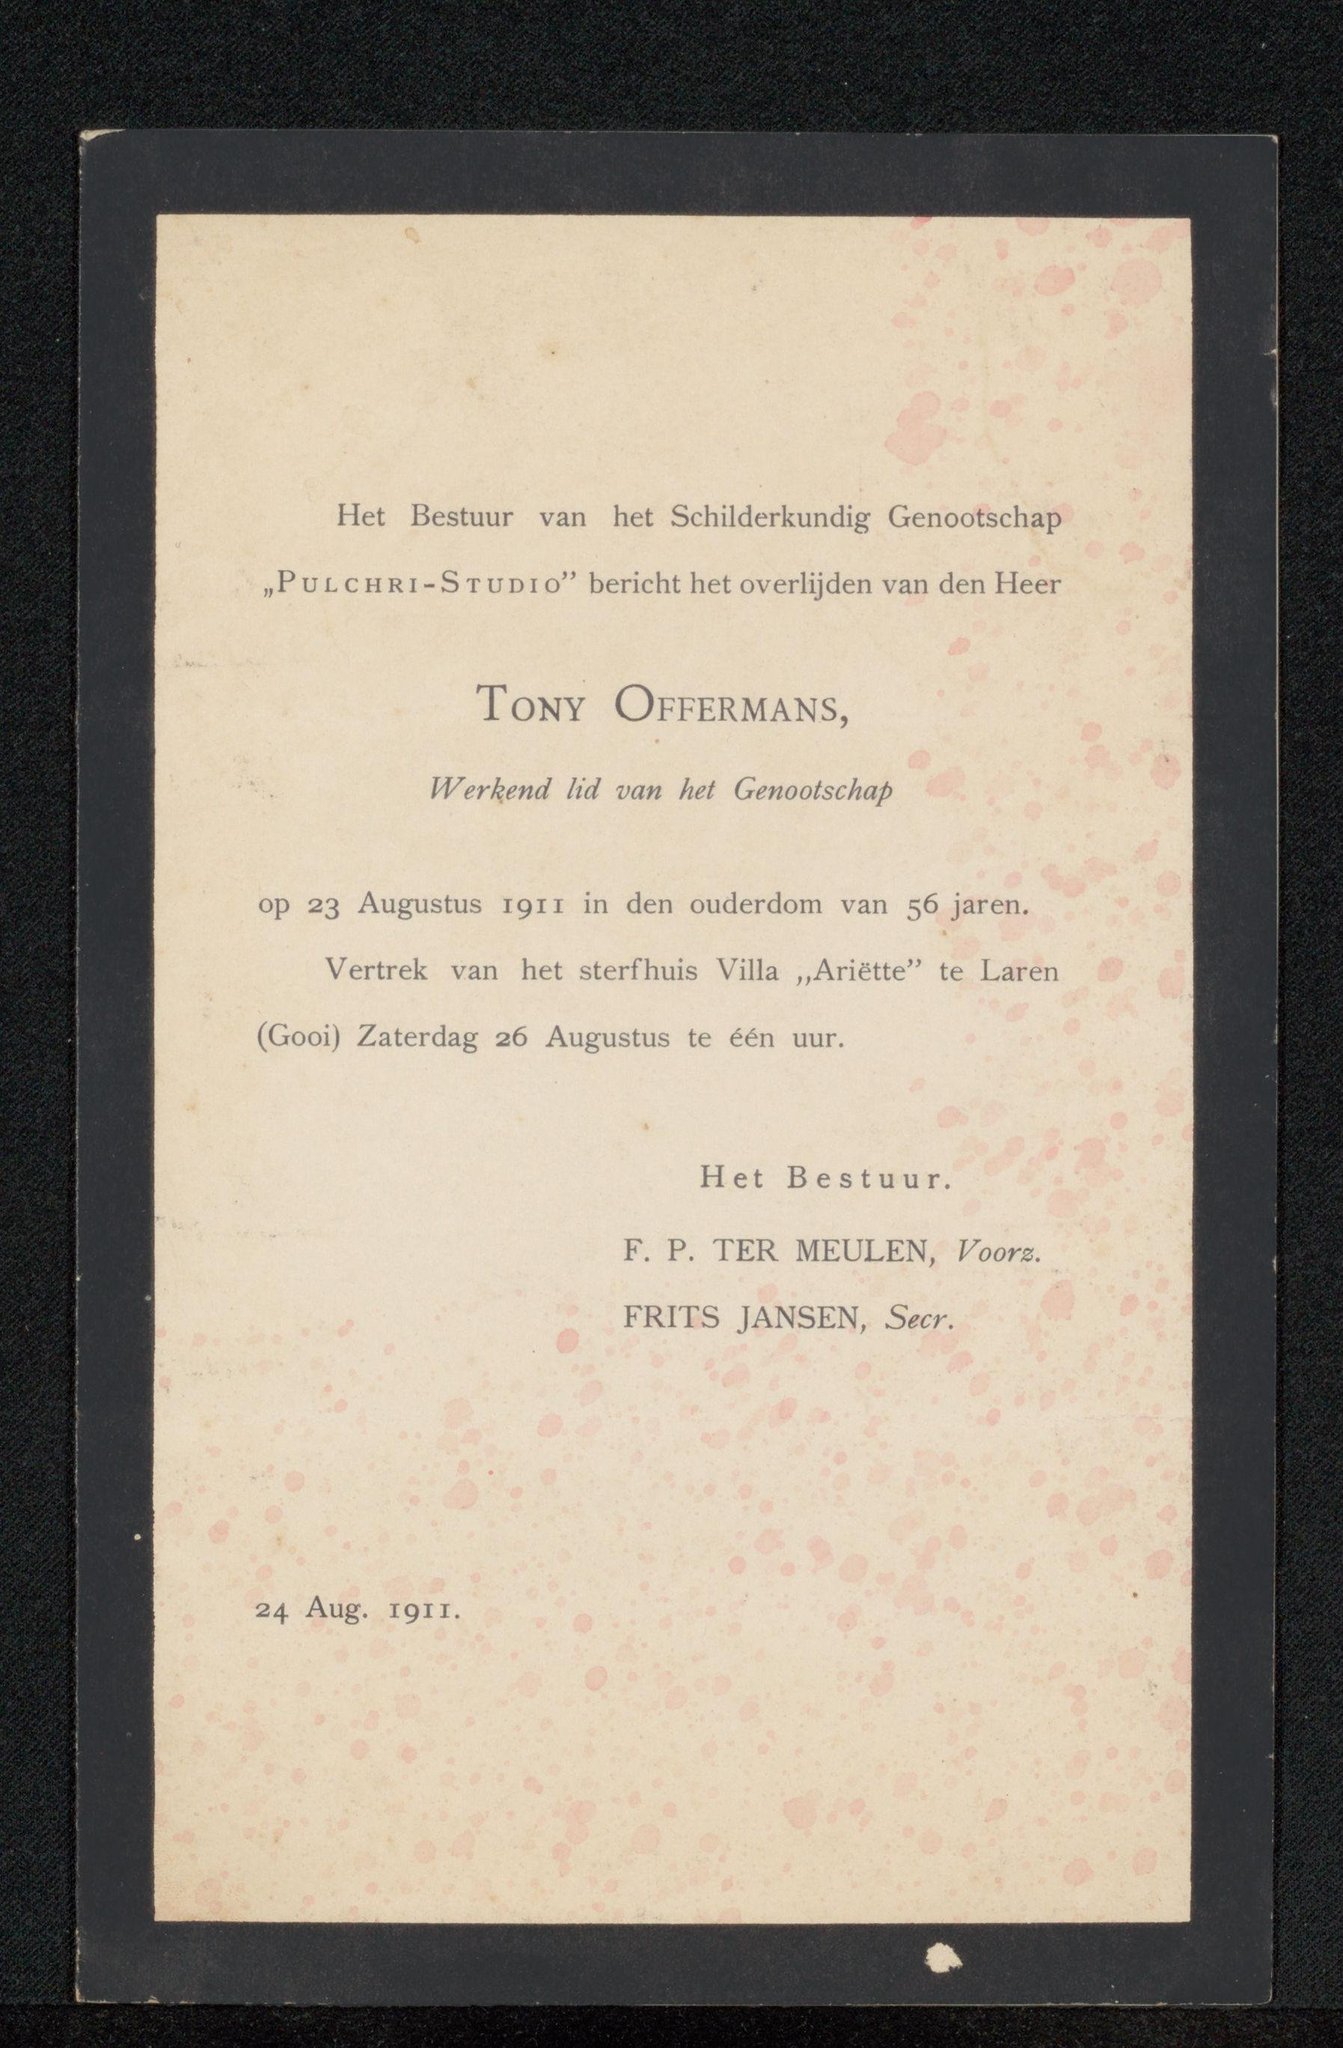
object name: overlijdensbericht, overlijdensadvertentie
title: Overlijdensbericht aan Philip Zilcken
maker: frits jansen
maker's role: painter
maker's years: 1856-1928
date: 1911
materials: ink, paper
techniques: pen, printing, writing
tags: the hague, tony lodewijk george offermans, painter, draughtsman, philip zilcken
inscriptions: collector's mark: ‘RPK’